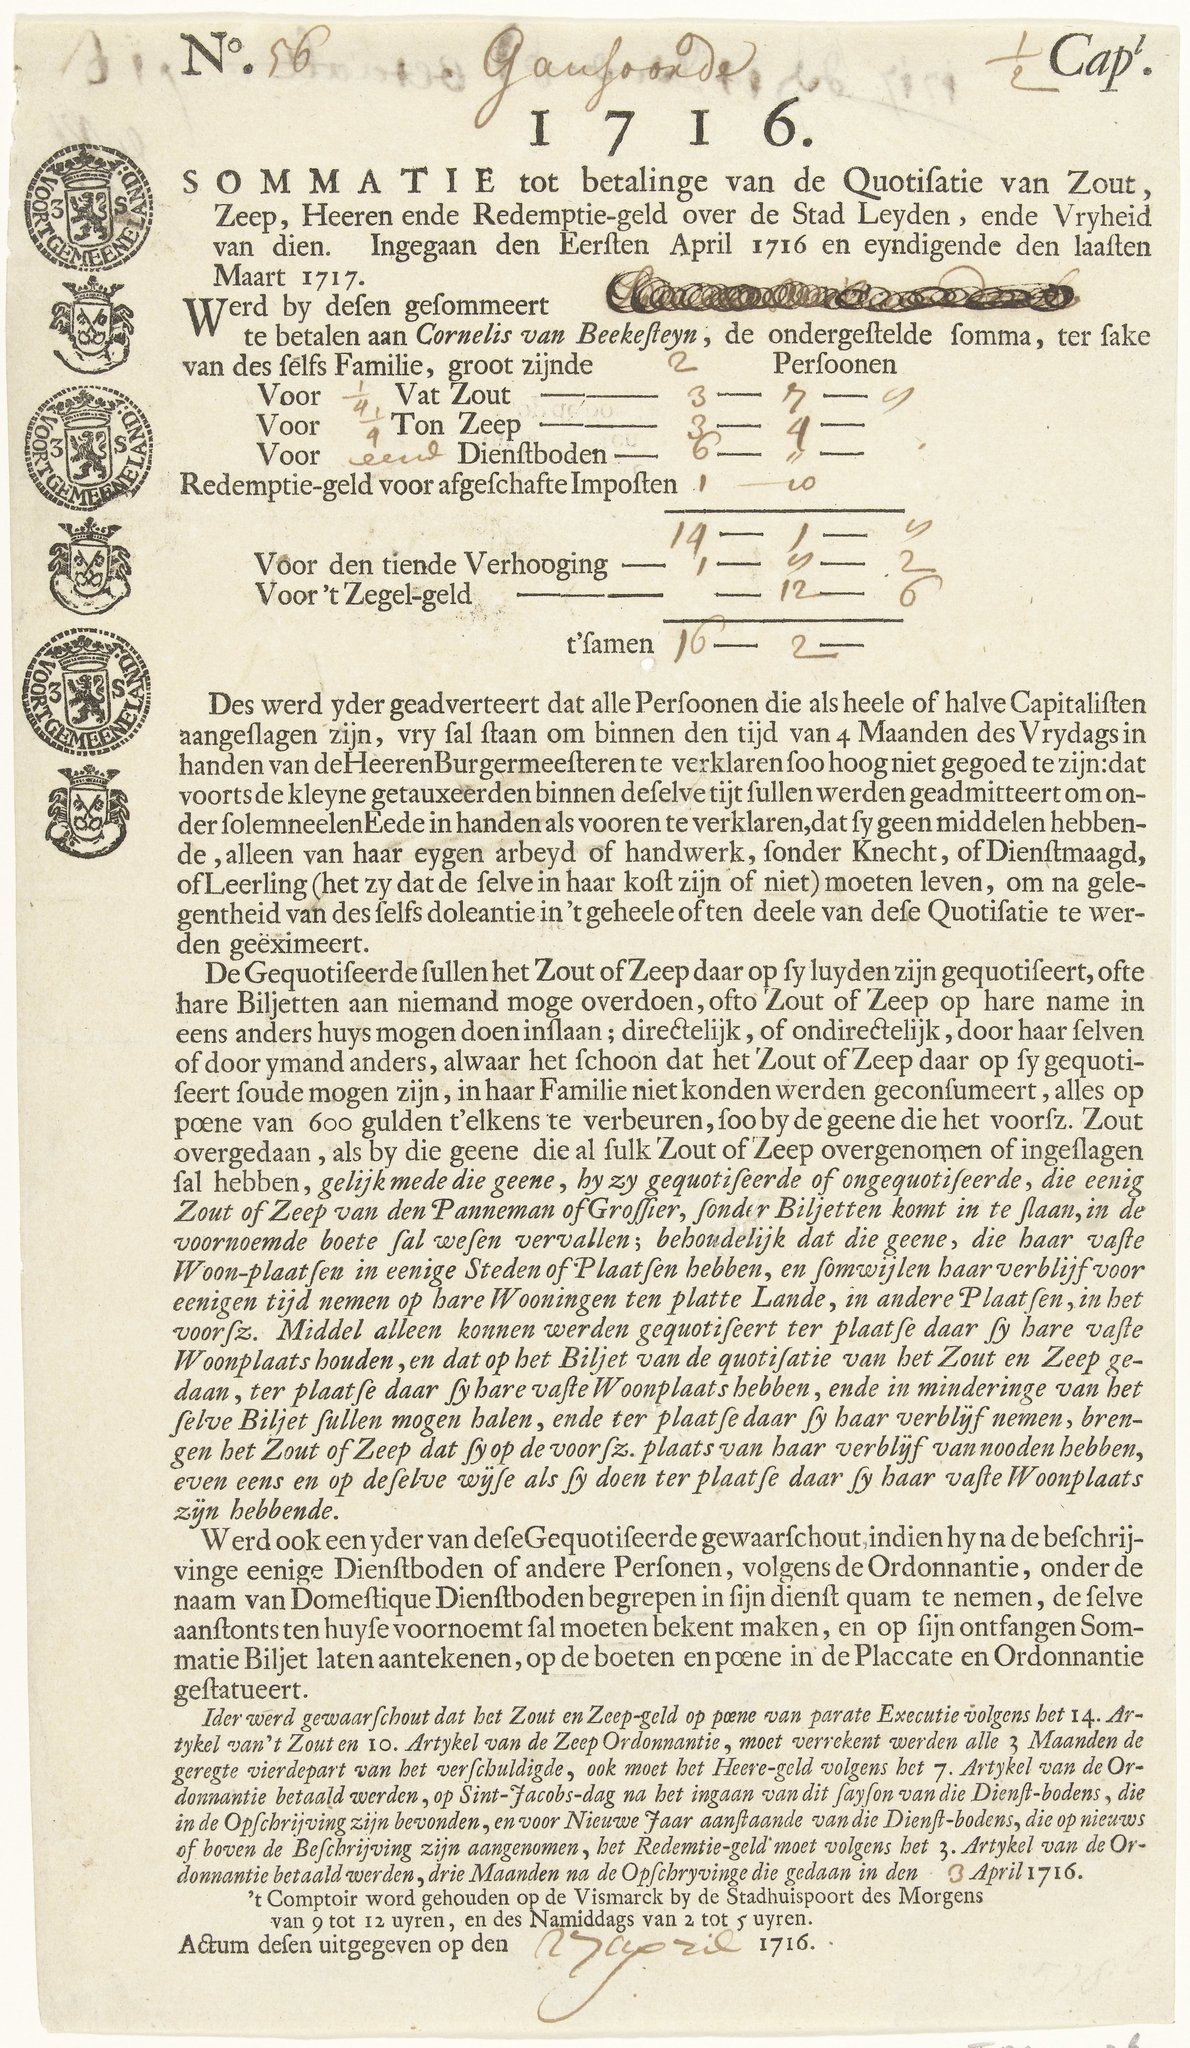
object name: document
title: Sommatie tot betalinge van de Quotisatie van Zout, Zeep, Heeren ende Redemptie-geld over de Stad Leyden, ende Vryheid van dien. Ingegaan den Eersten April 1716 en eyndigende den laasten Maart 1717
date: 1716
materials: paper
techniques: letterpress printing, writing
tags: tax collection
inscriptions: collector's mark: Lugt 2228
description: Belastingdocument van de gemeente Leiden met een sommatie tot het betalen voor zout, zeep, etc. voor het jaar 1716-1717. Voorgedrukt formulier met pen en inkt ingevuld, de naam doorgehaald. Opgemaakt te Leiden met de datum 27 april 1716.